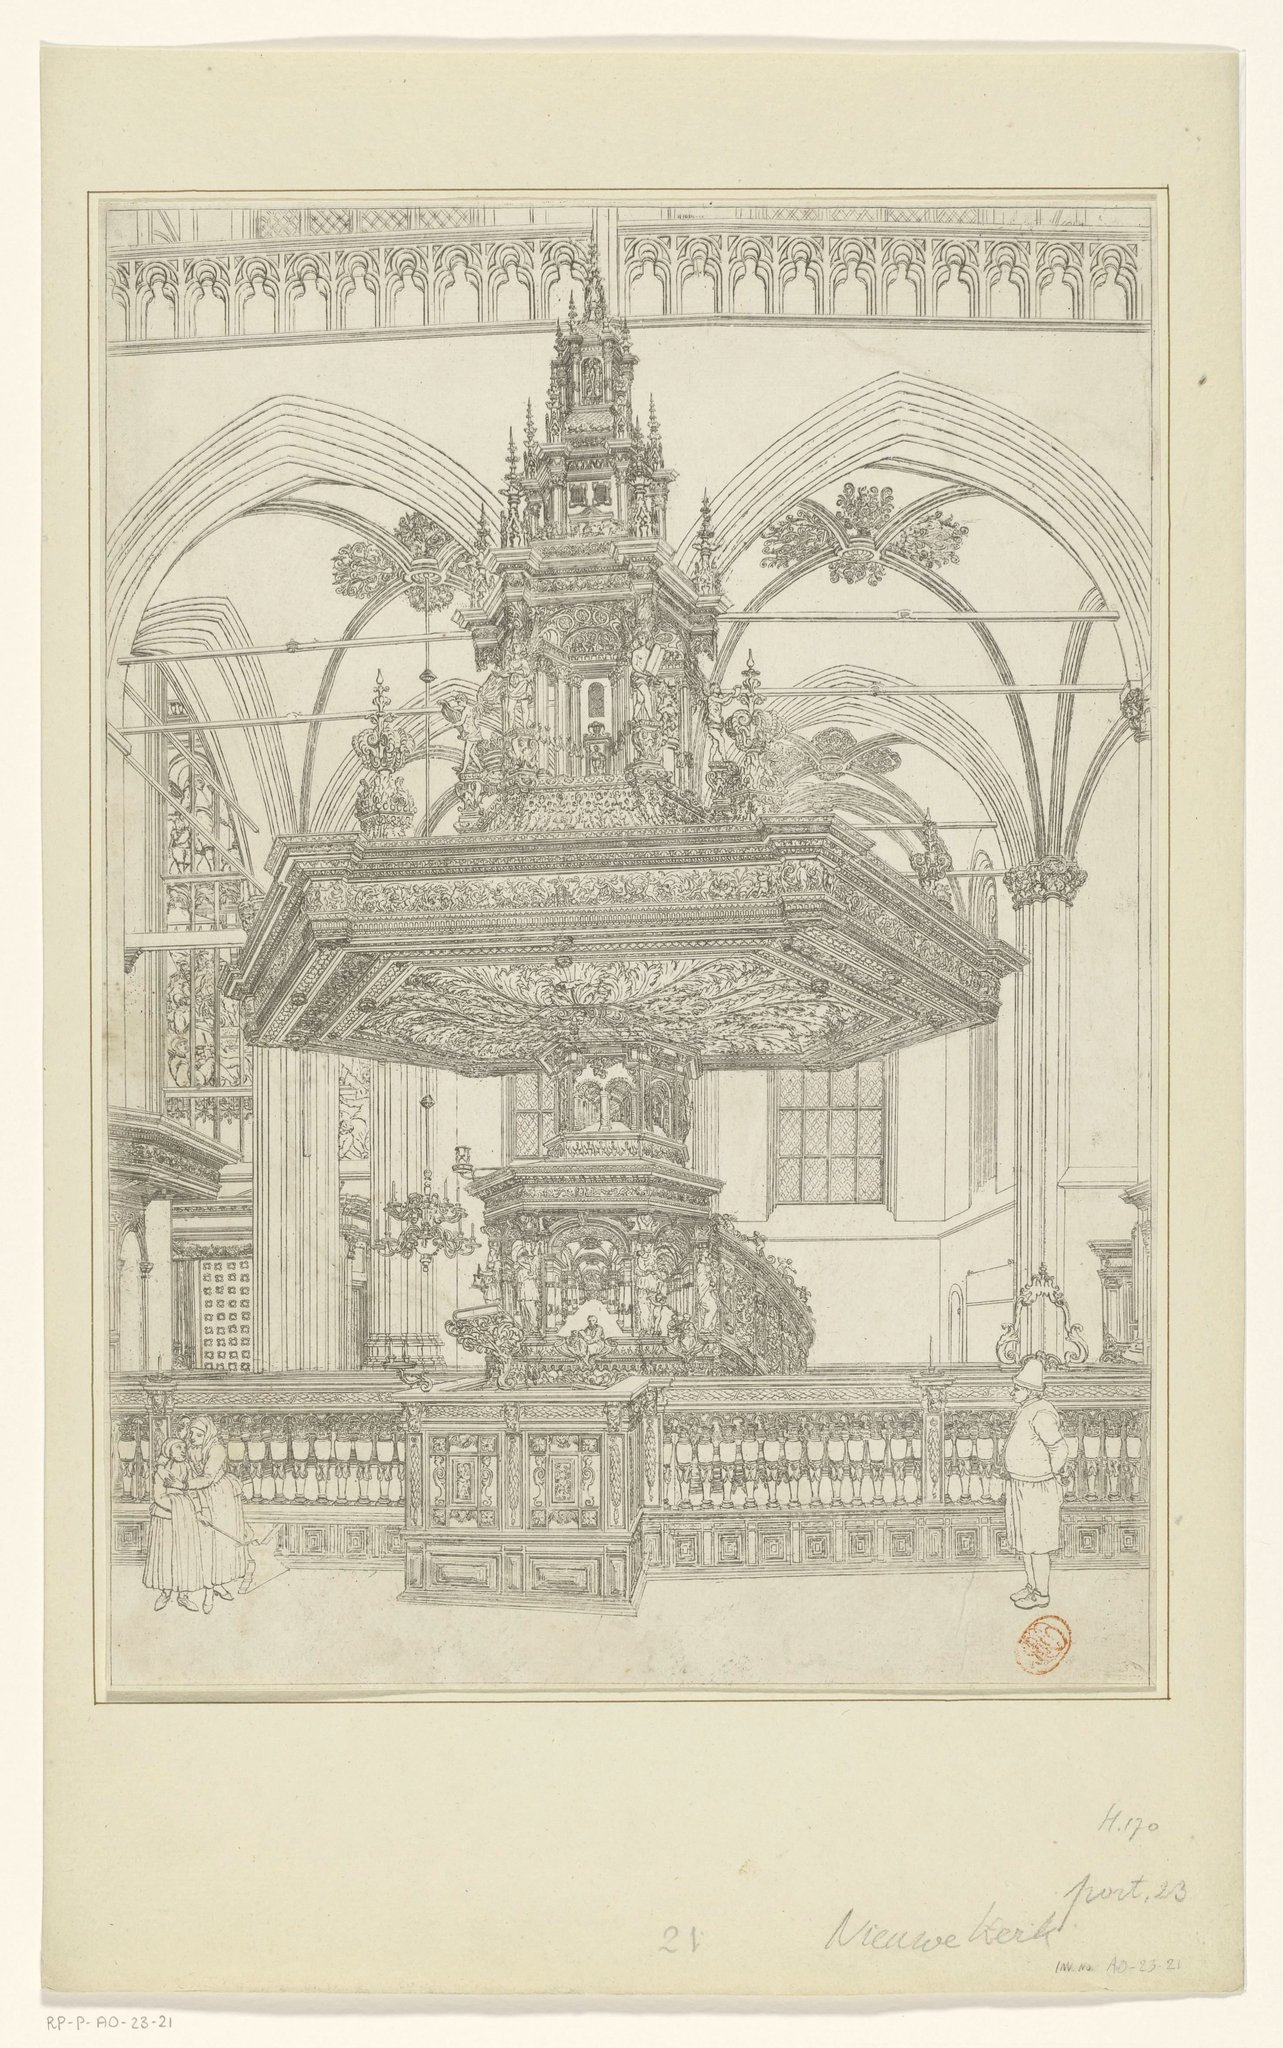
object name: print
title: Preekstoel in de Nieuwe Kerk in Amsterdam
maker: pieter holsteyn (ii)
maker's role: draughtsman, print maker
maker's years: 1614-1673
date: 1649-1673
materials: paper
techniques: etching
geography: northern netherlands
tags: amsterdam, sculptor, albert jansz vinckenbrinck, interior of church, pulpit, ambo, chancel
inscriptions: collector's mark: Lugt 195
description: Na de brand van 1645 kreeg beeldhouwer Albert Jansz. Vinckenbrinck opdracht voor het maken van een nieuwe preekstoel voor de Nieuwe Kerk. Bekend is dat hij van 1649 tot 1664 werkte aan deze preekstoel. In de collectie van het Stadsarchief Amsterdam bevindt tegendruk van deze ets die met zwarte inkt is ingekleurd en bijgewerkt. Op dit exemplaar staat linksonder 'J. v.d. Heyden, anno 1649' geschreven. De naam van Van der Heyden zorgt voor verwarring rondom het auteurschap van deze prent, die is geëtst door Pieter Holsteyn (II). Ook het jaartal 1649 is verwarrend, aangezien de preekstoel toen nog niet klaar was. Als het jaartal en de naam daadwerkelijk in 1649 op deze prent zijn geschreven is het aannemelijk dat een J. van der Heyden in 1649 zijn naam heeft gezet op een door hem ingekleurde tegendruk van de door Pieter Holsteyn (II) gemaakte prent. Dat dit al in 1649 was impliceert dat de prent is gemaakt naar een ontwerp van de preekstoel, die in de daaropvolgende jaren gerealiseerd zou worden.